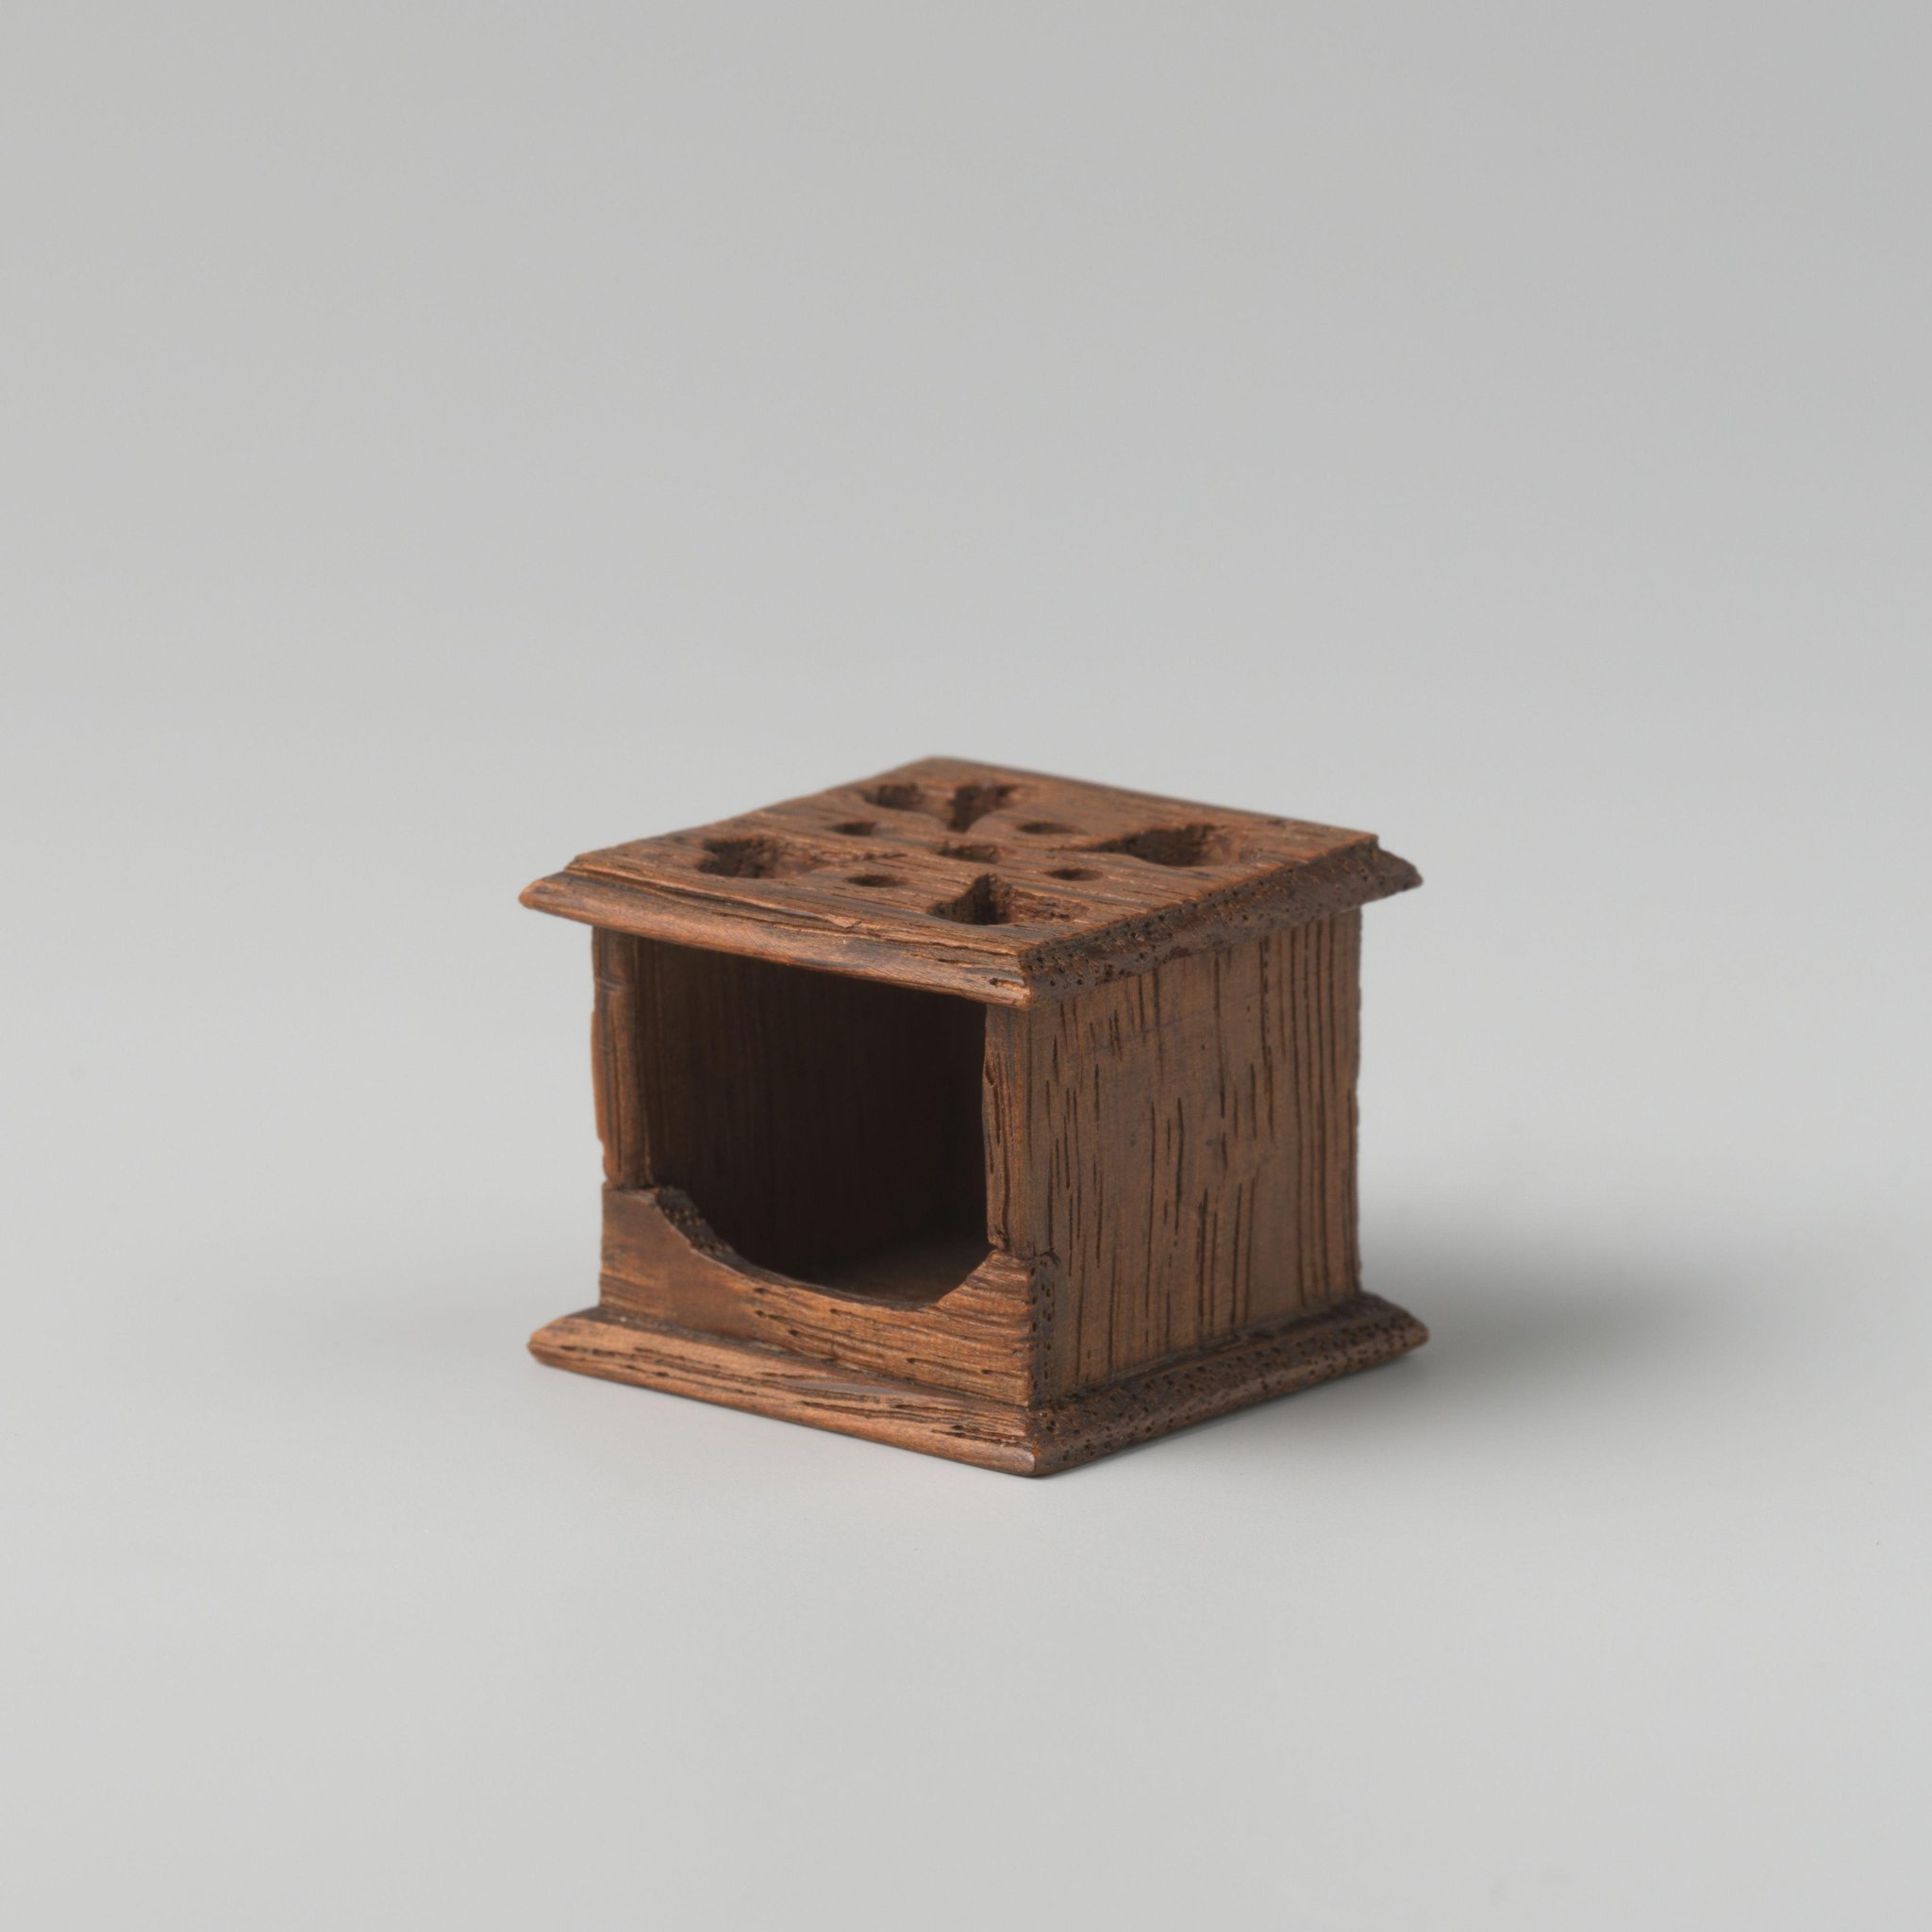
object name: voetstoof, stoof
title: Vierkante stoof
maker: Anonymous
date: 1690-1710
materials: wood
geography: amsterdam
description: Vierkante stoof van eikenhout. De stoof heeft een opstaande rand aan de voorzijde en in de voetenplank zijn vier hartvormige en vijf ronde gaten aangebracht.